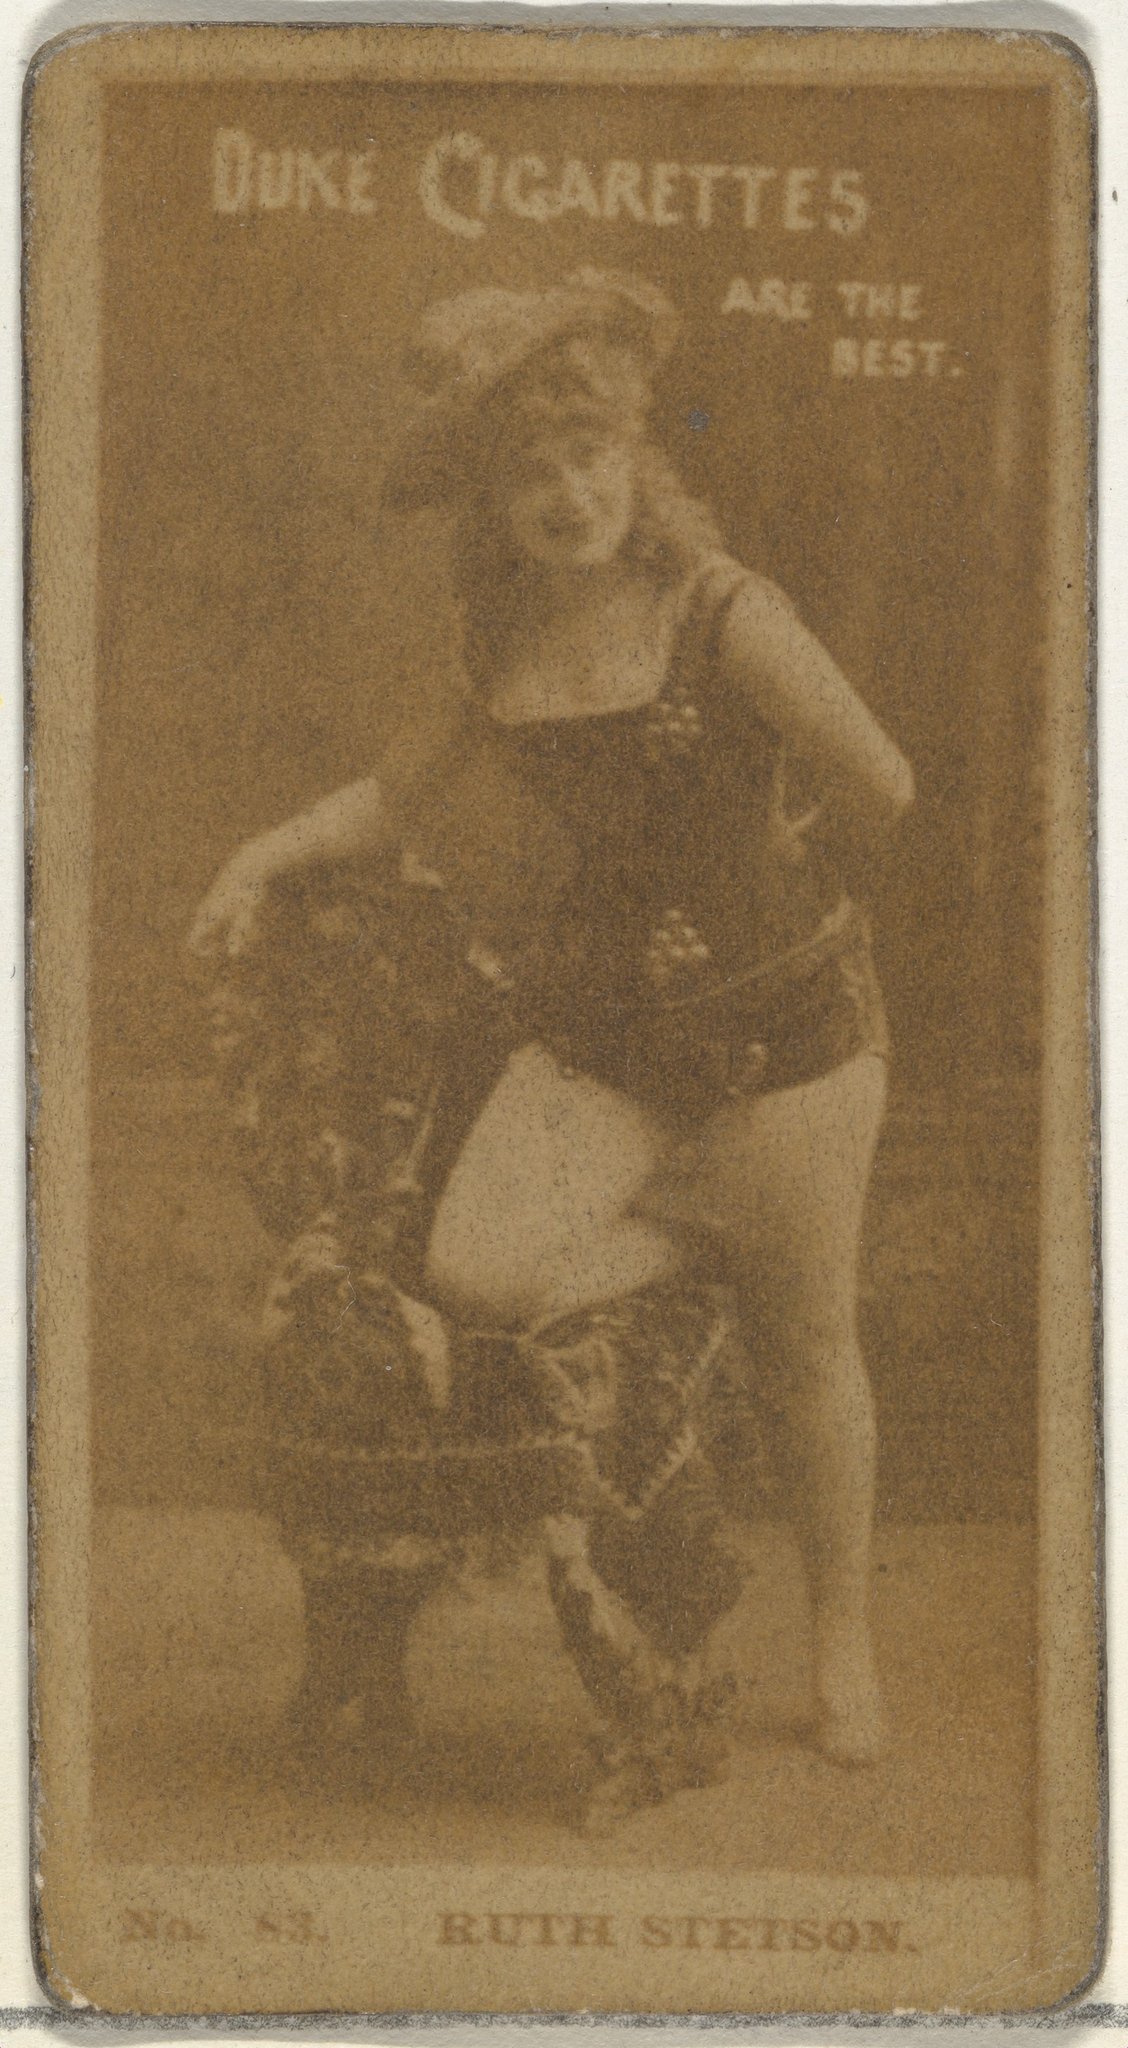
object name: photograph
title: Card Number 83, Ruth Stetson, from the Actors and Actresses series (N145-6) issued by Duke Sons & Co. to promote Duke Cigarettes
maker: w. duke, sons & co.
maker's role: publisher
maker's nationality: american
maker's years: 1870-1920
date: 1880-1889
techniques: albumen silver print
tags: portraits,women,actresses